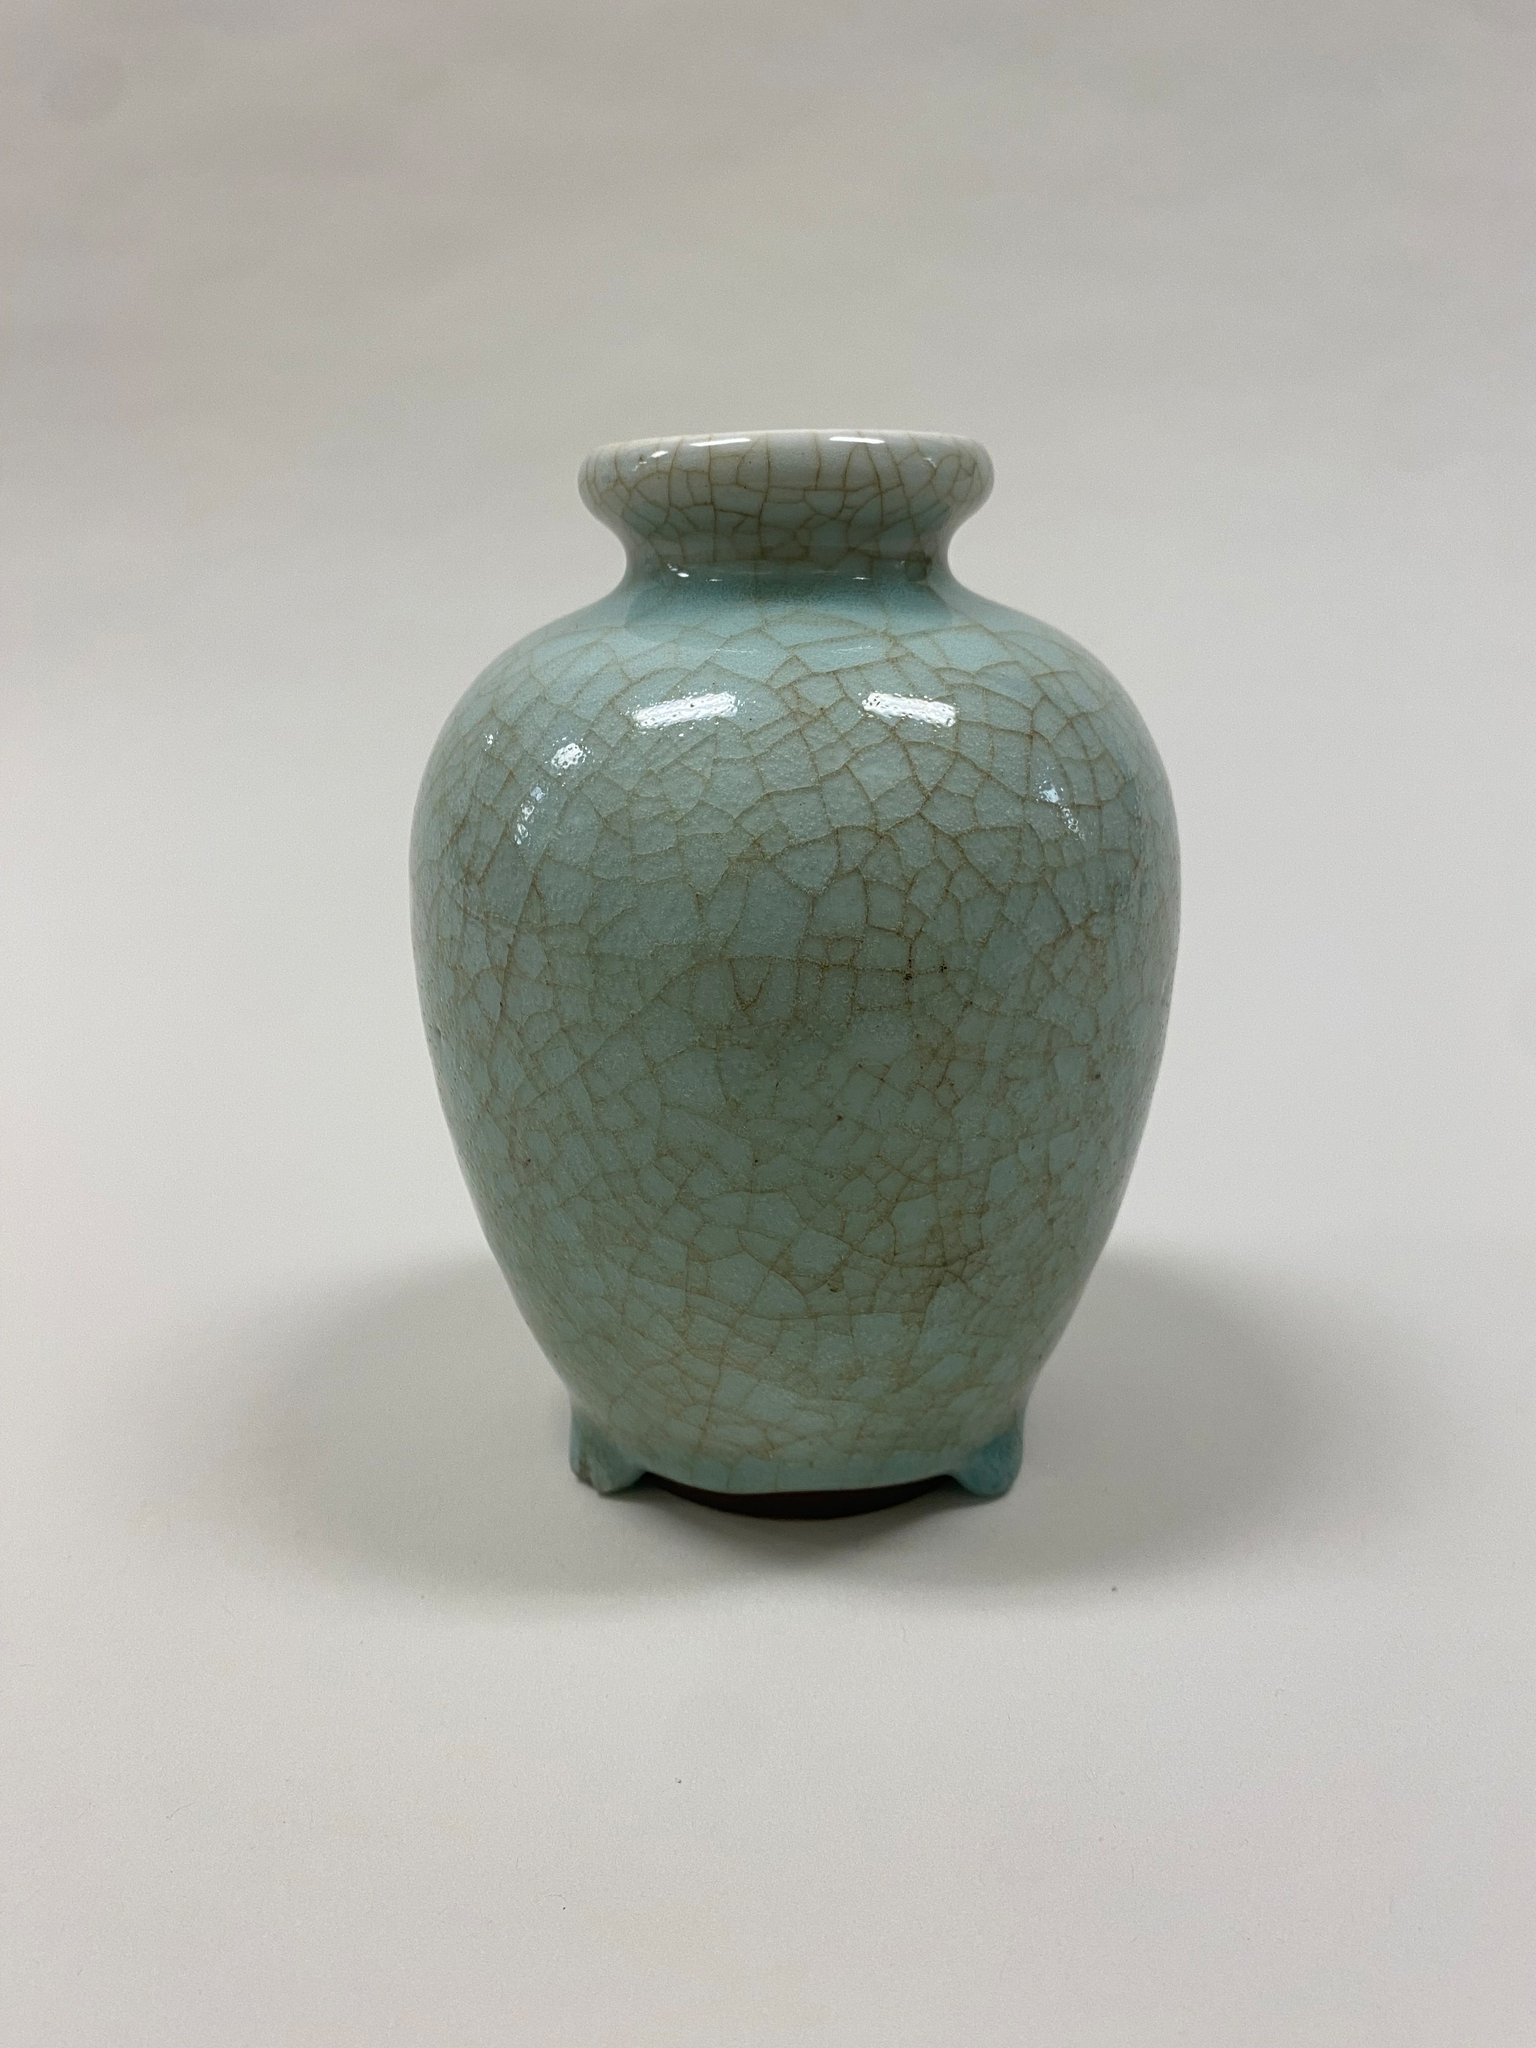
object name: jar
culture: chinese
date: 1701-1733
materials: cobalt, porcelain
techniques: painting, underglaze